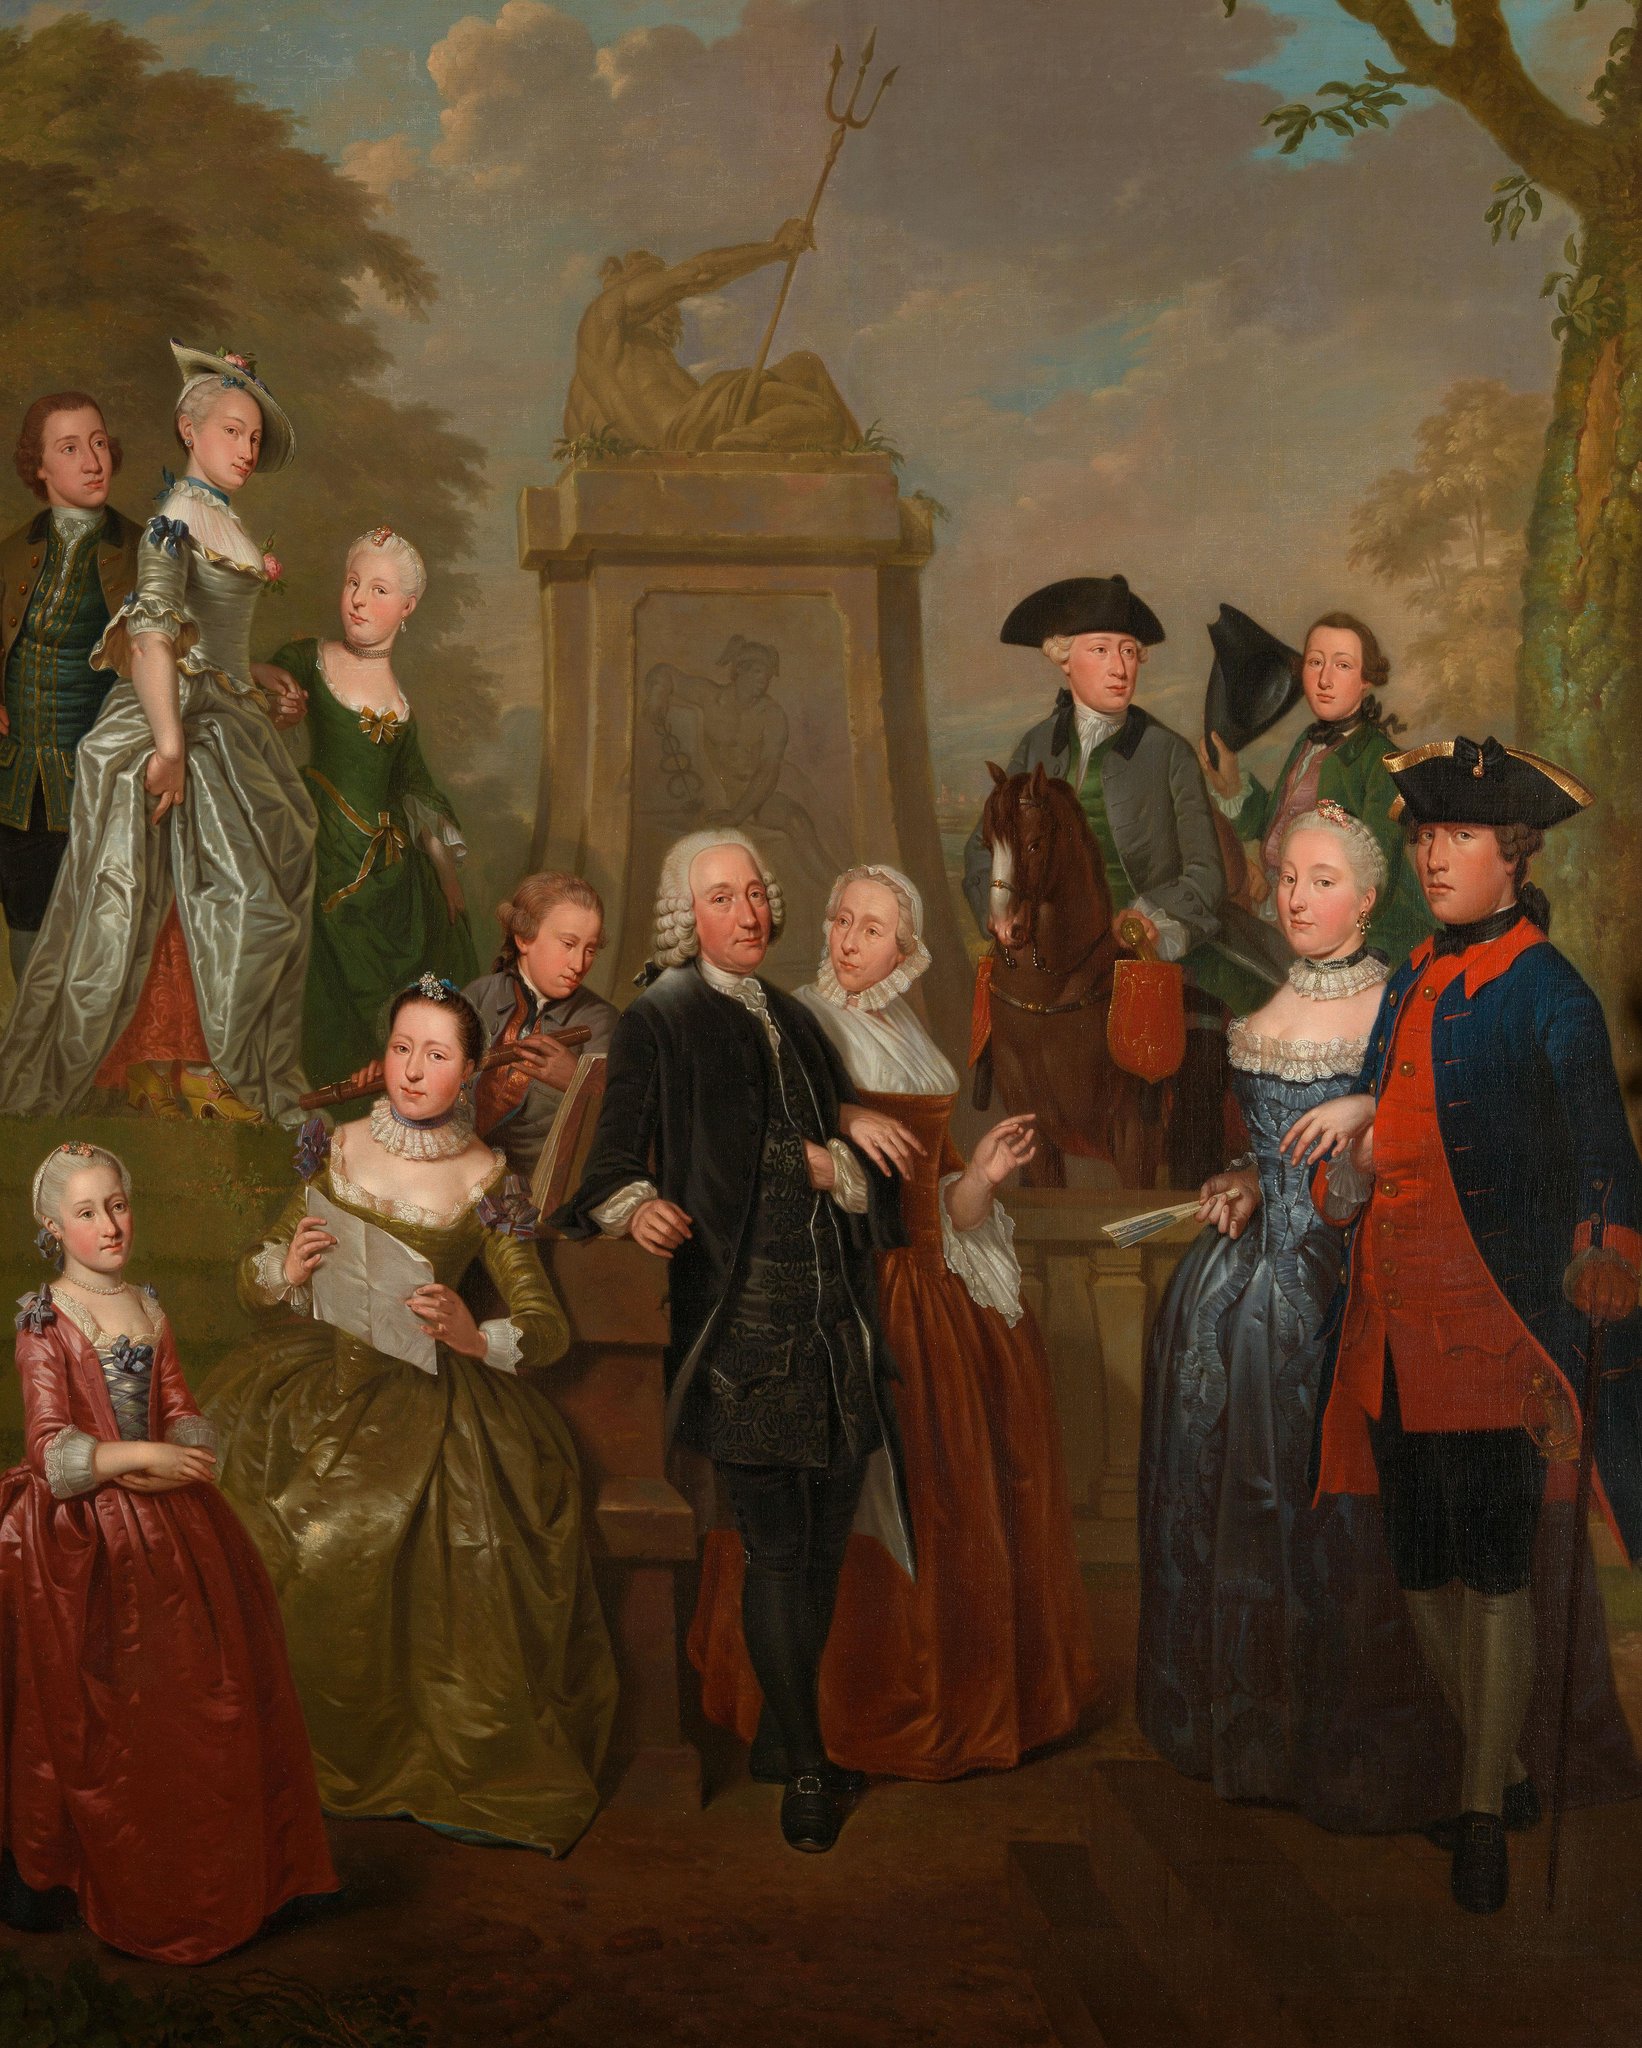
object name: painting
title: Portrait of Theodorus Bisdom van Vliet and his Family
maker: jan stolker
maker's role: draughtsman, painter, print maker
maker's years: 1724-1785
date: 1757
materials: canvas, oil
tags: mayor, (story of) neptune (poseidon), family group, especially parents with their child(ren), piece of sculpture, reproduction of a piece of sculpture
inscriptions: signature and date: ‘J. Stolker Pinx. 1757’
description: Theodorus Bisdom van Vliet, burgomaster of Haastrecht, had himself and his family portrayed as though they were nobility. The family owned the De Herstelling plantation in Demerary, a Dutch colony west of Suriname. The eldest son Cornelis, here at the far left, ran it. After his death, his brothers sold the plantation along with the 30 men, 26 women and 10 children who lived and worked there in slavery.